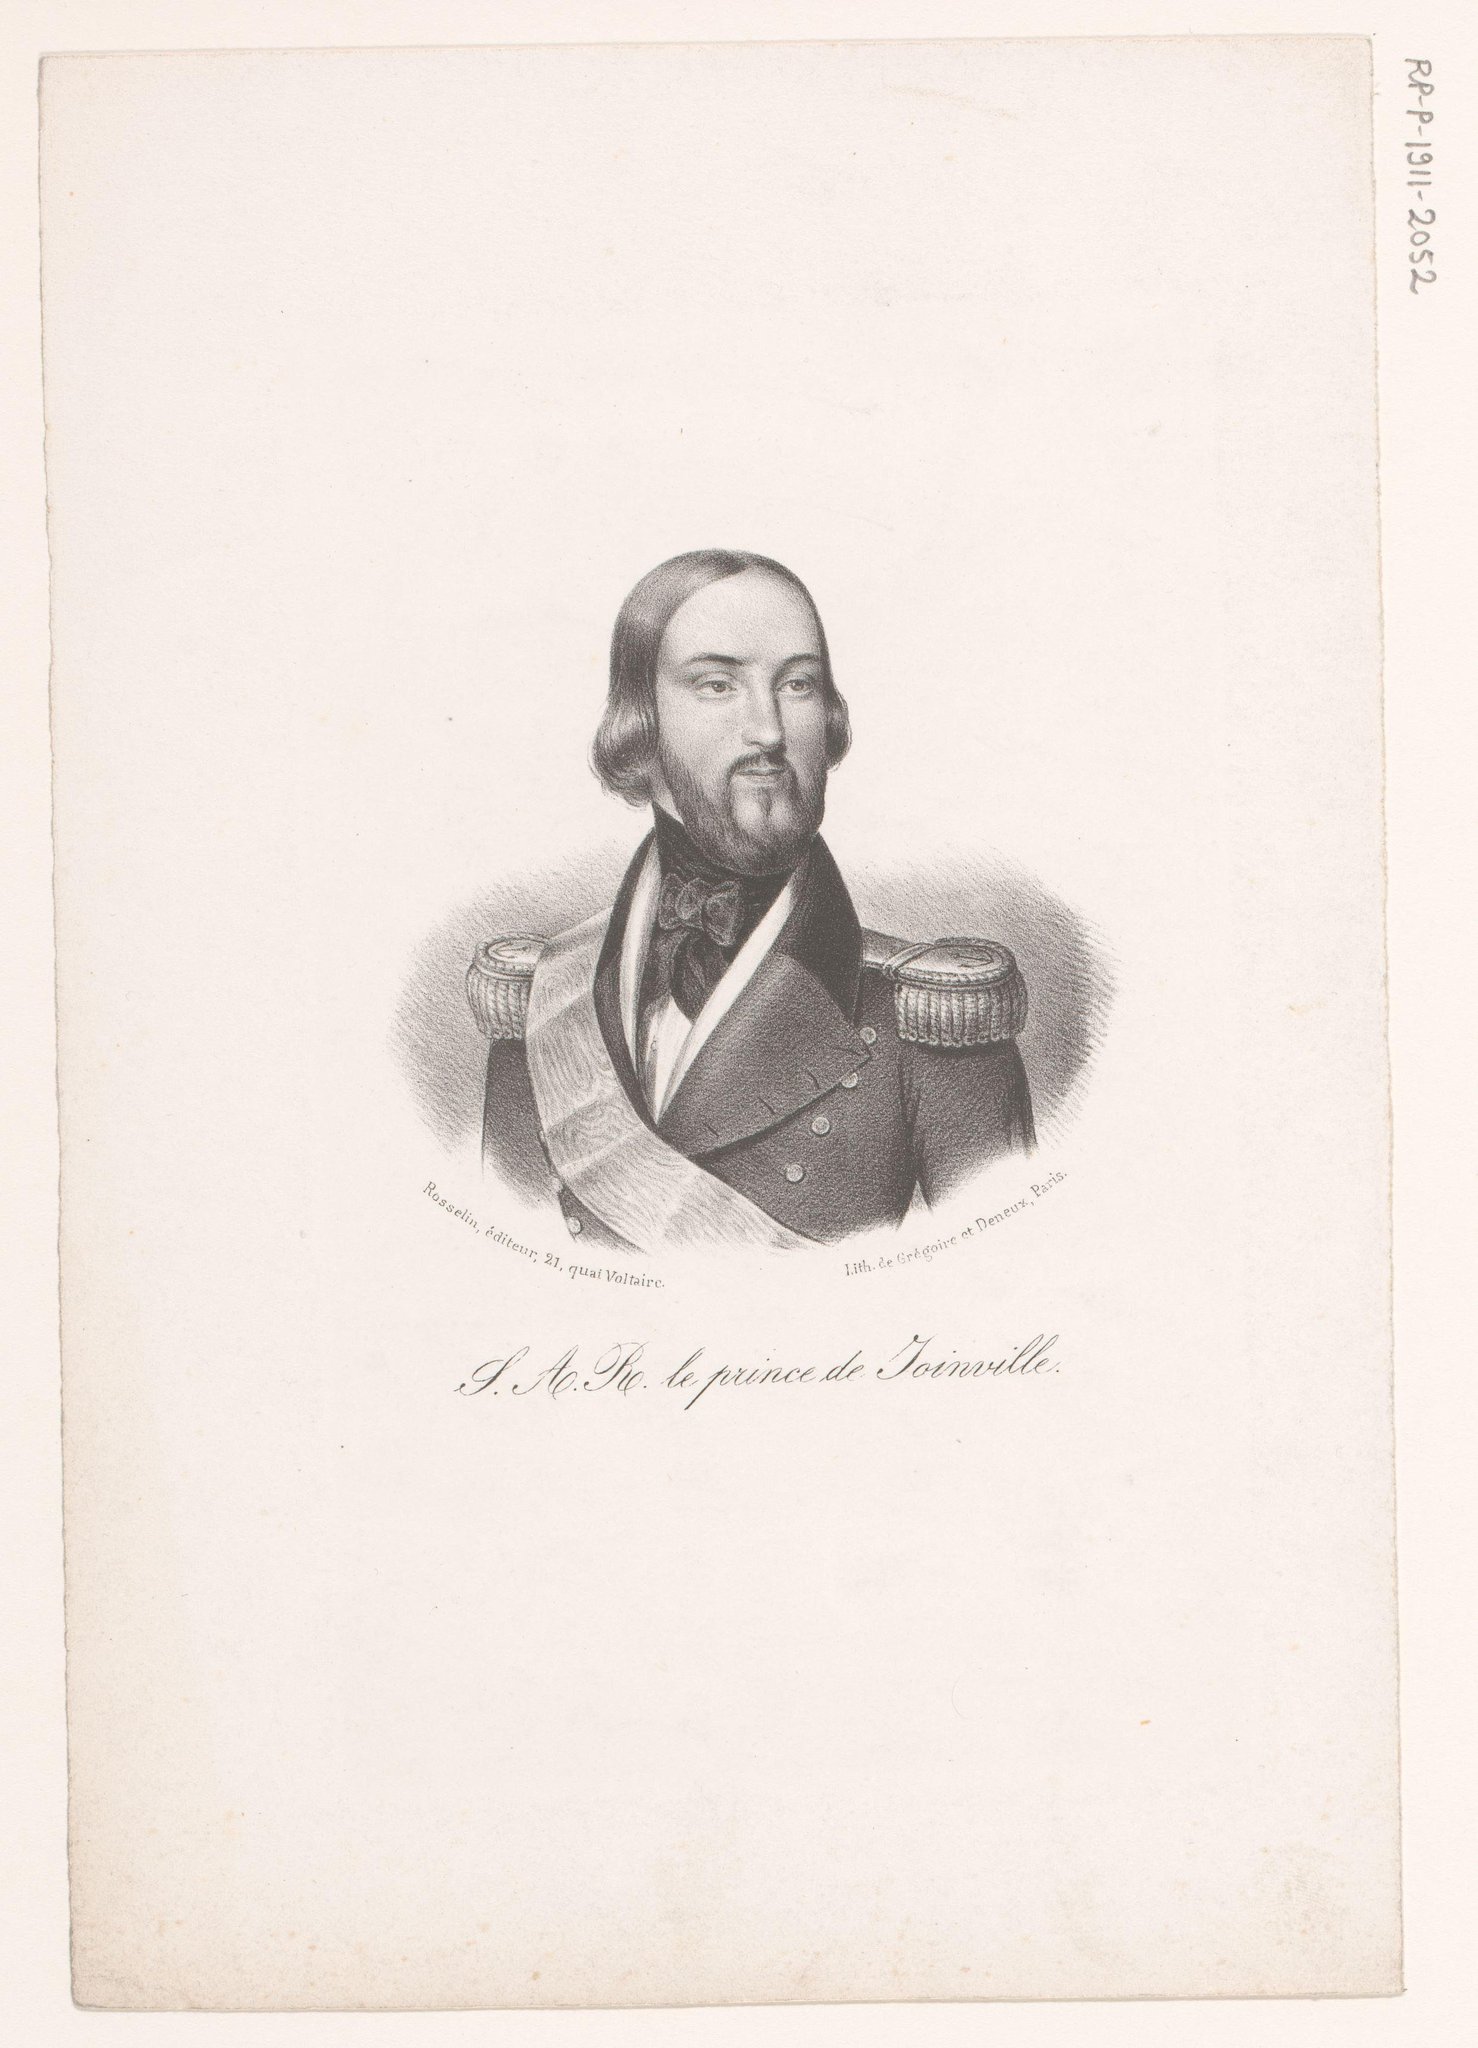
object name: print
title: Portret van Frans Ferdinand van Orléans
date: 1844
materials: paper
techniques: lithograph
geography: paris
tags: paris, frans van orléans (prins van joinville), historical persons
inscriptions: collector's mark: Lugt 2228a